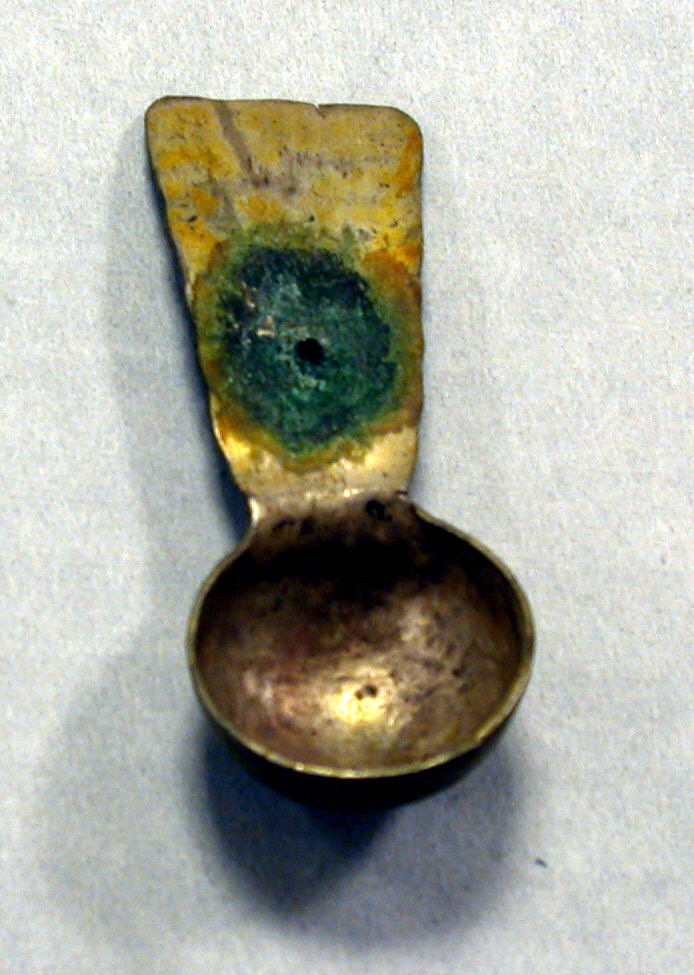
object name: spoon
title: Hammered Silver Spoon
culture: peruvian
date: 701-1566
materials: gilt, silver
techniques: hammering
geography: peru